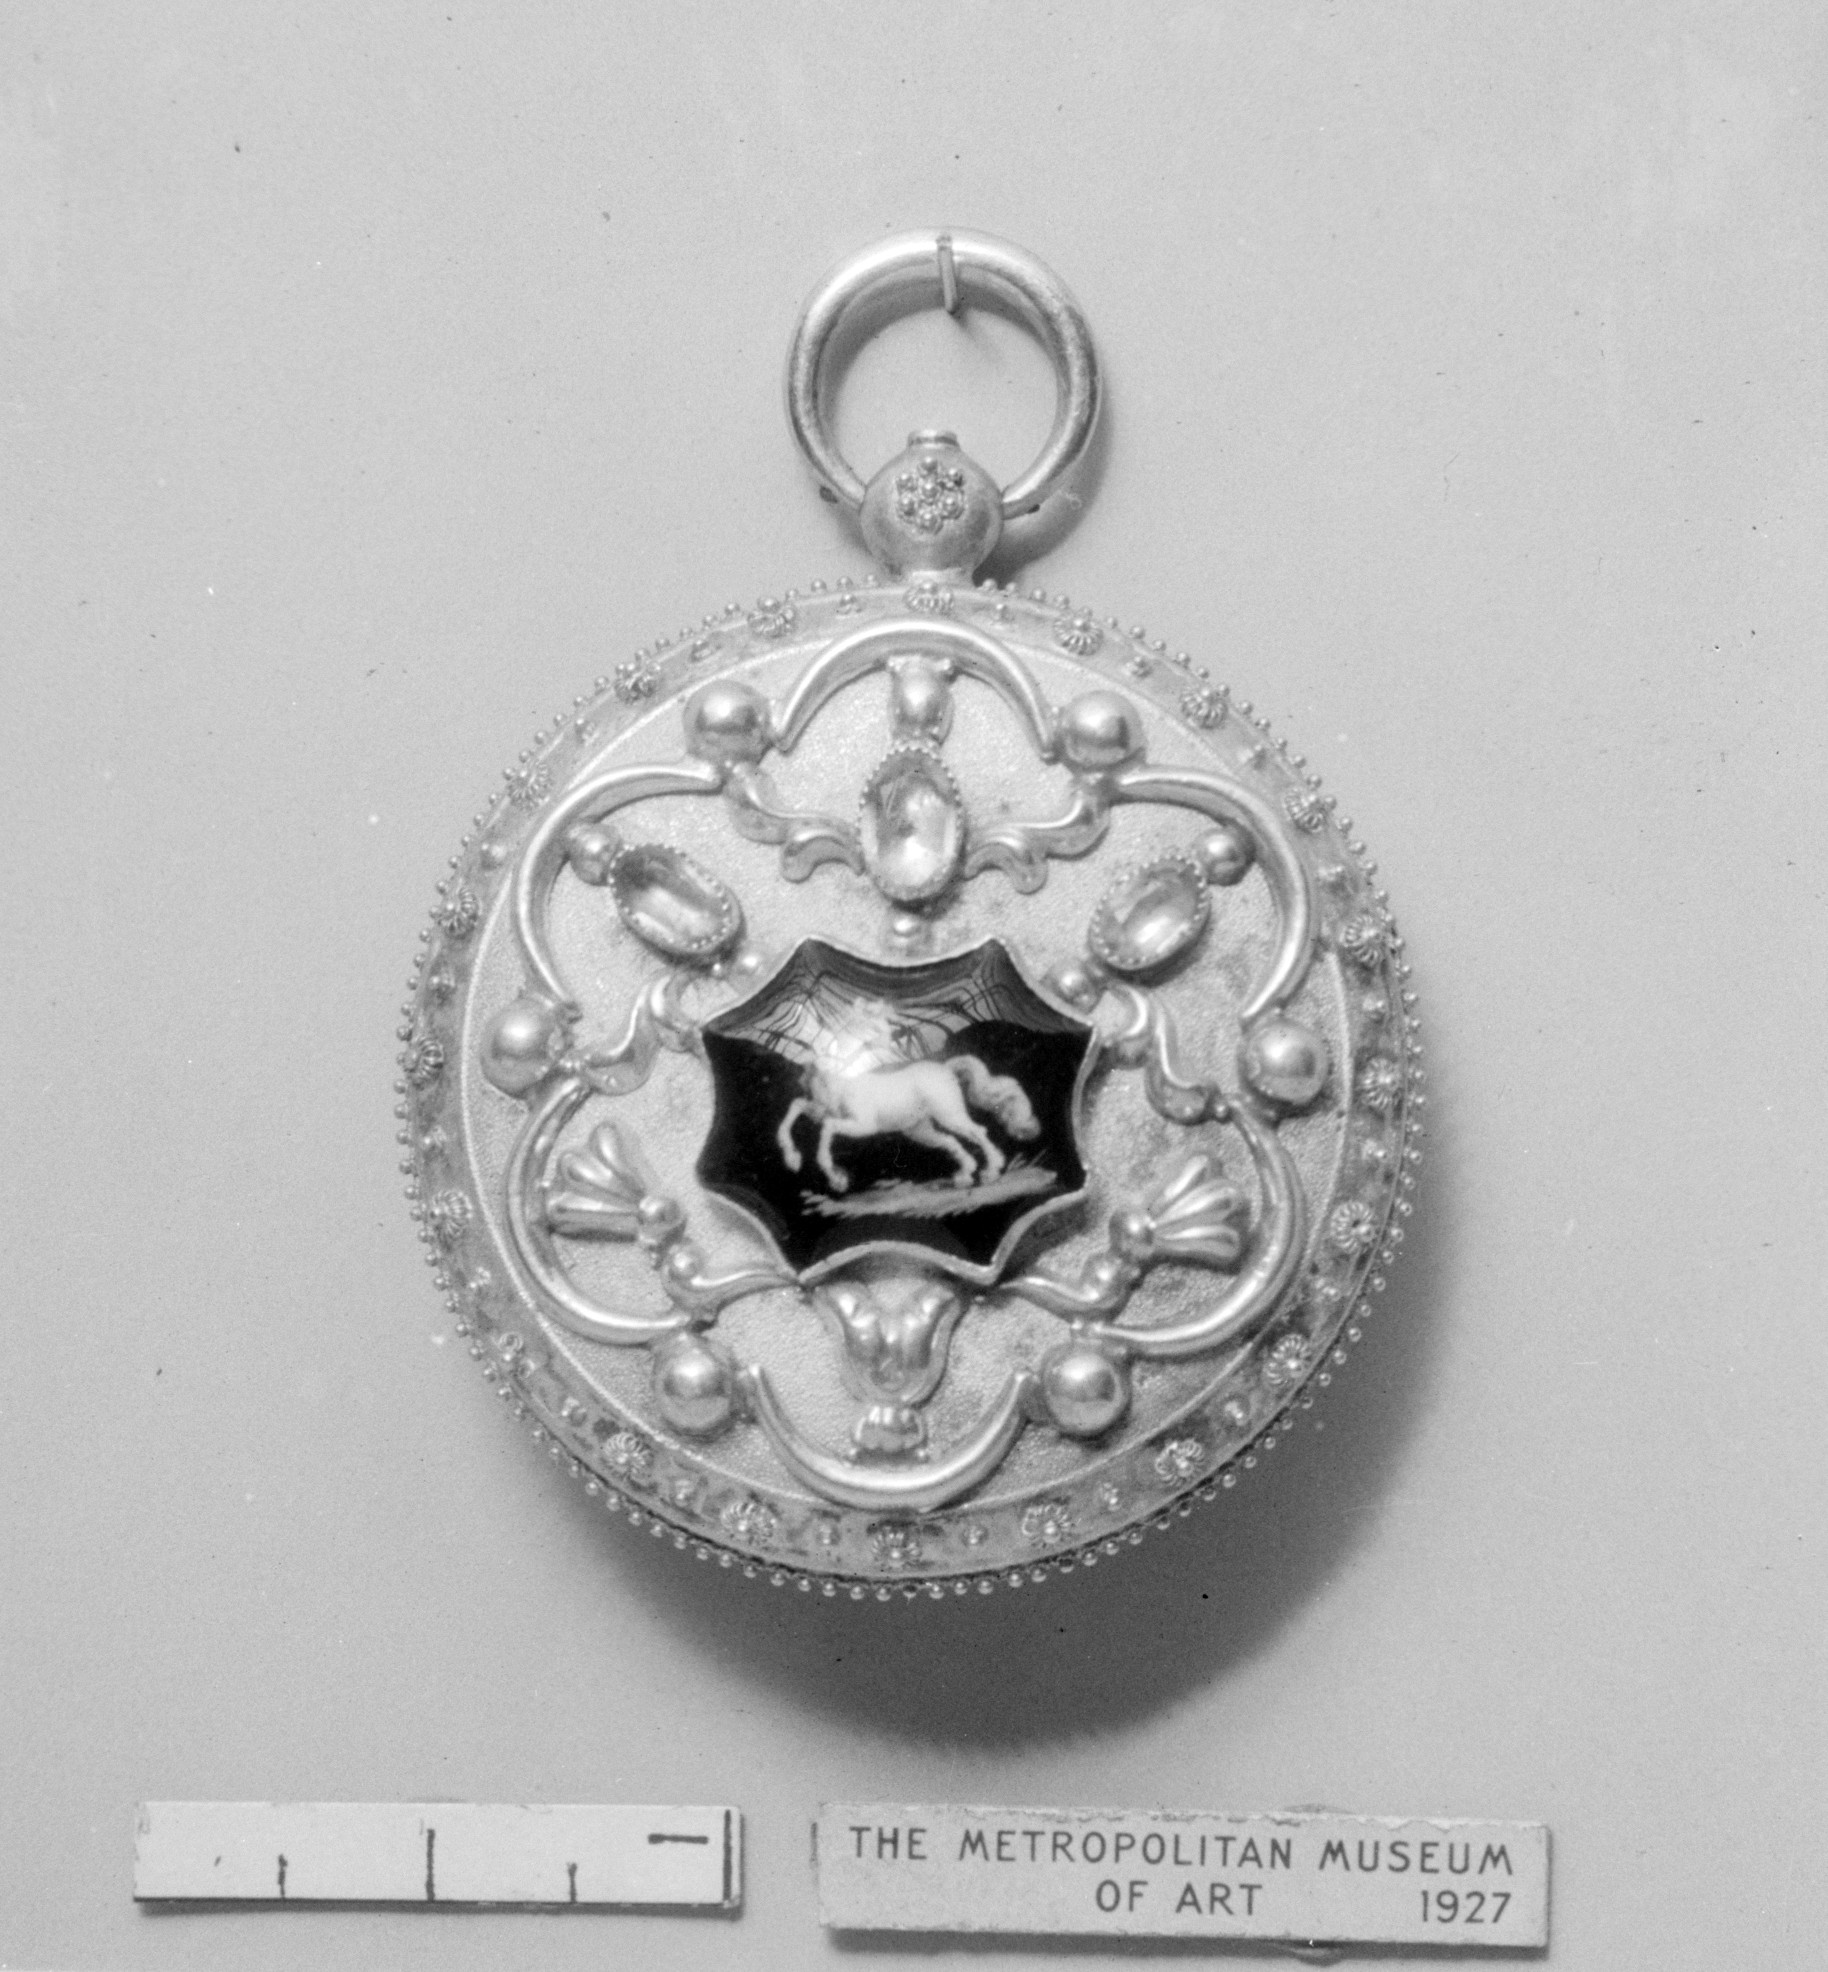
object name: watch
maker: firm of guirodon et cie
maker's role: maker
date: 1815-1830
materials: enamel, gold, silver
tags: horses